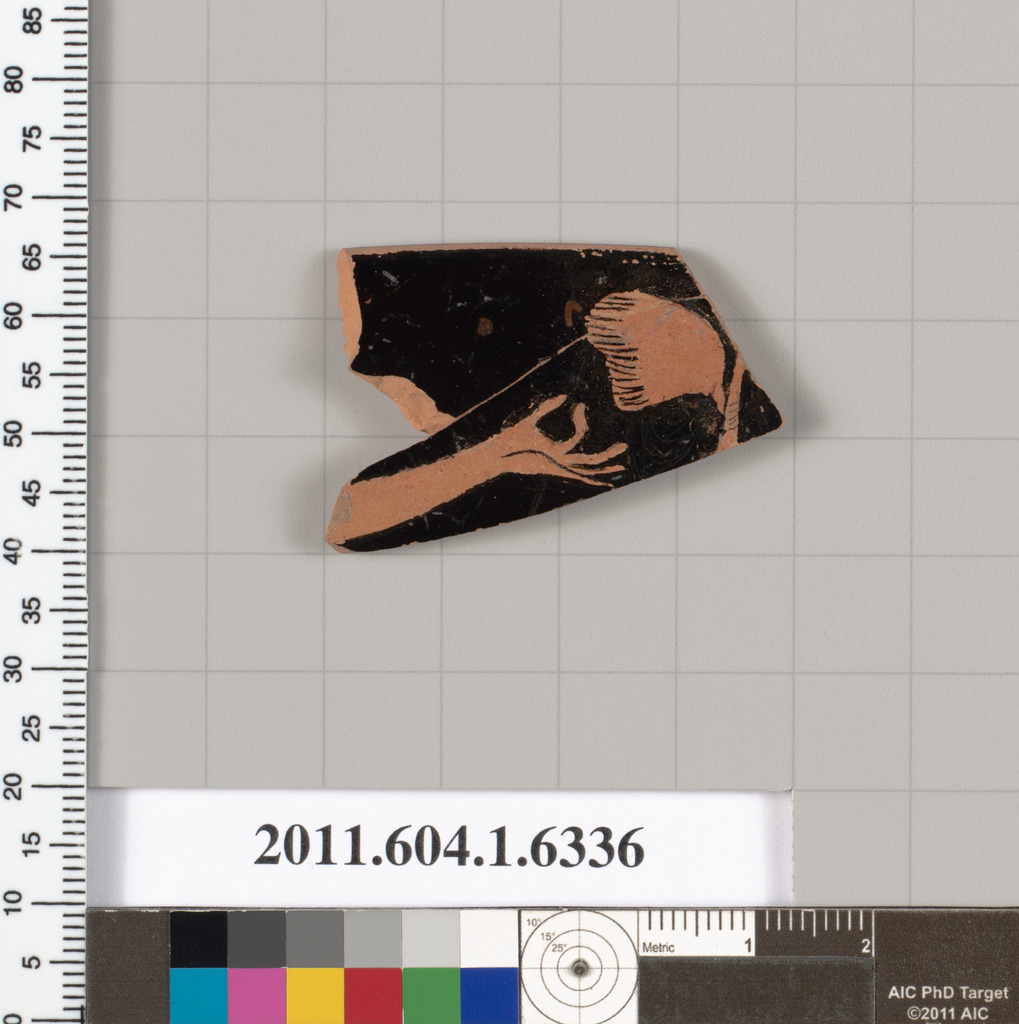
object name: kylix fragment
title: Terracotta rim fragment of a kylix (drinking cup)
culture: greek, attic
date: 500-480 BCE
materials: terracotta